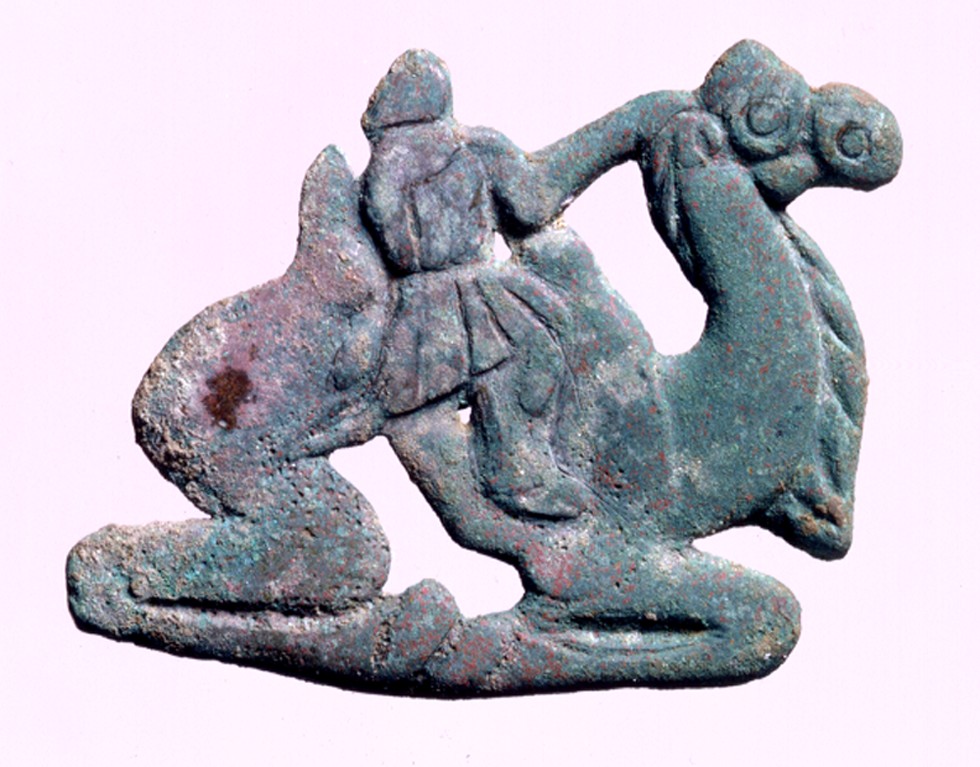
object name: belt plaque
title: Belt Plaque in the Shape of a Bactrian Camel with Rider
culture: northwest chinese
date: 400-301 BCE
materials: bronze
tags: camels